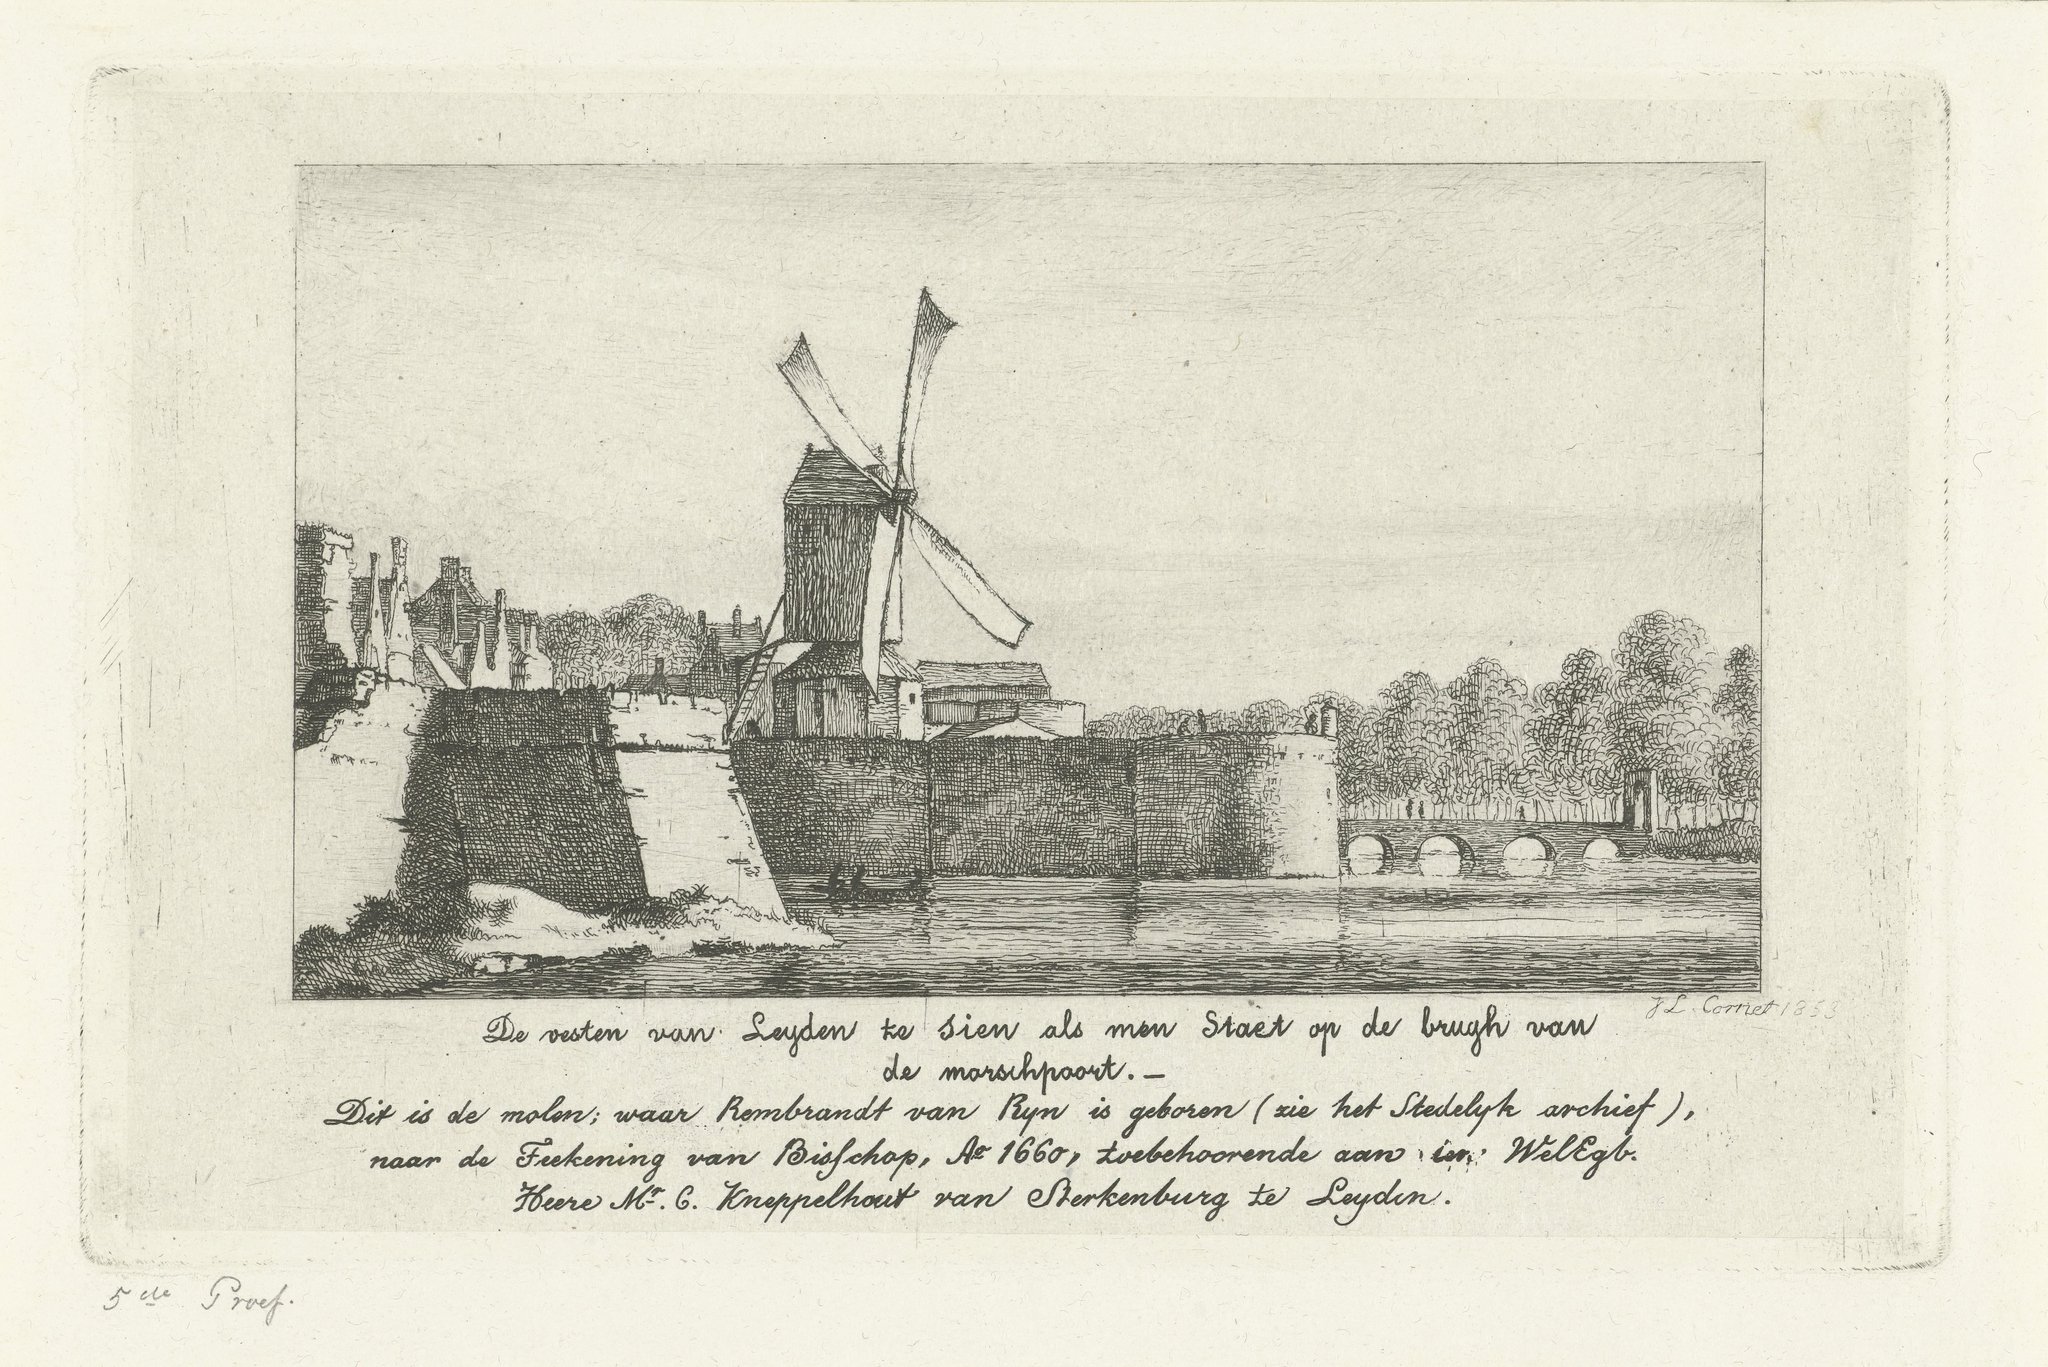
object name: print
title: Gezicht op de vesten van Leiden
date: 1853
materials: paper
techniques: etching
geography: leiden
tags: leiden, amsterdam, painter, print maker, draughtsman, rembrandt van rijn, city-walls, windmill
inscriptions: collector's mark: Lugt 2166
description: Gezicht op de vesten van Leiden. Op de achtergrond de molen waar Rembrandt van Rijn geboren werd. De prent heeft een Nederlands onderschrift